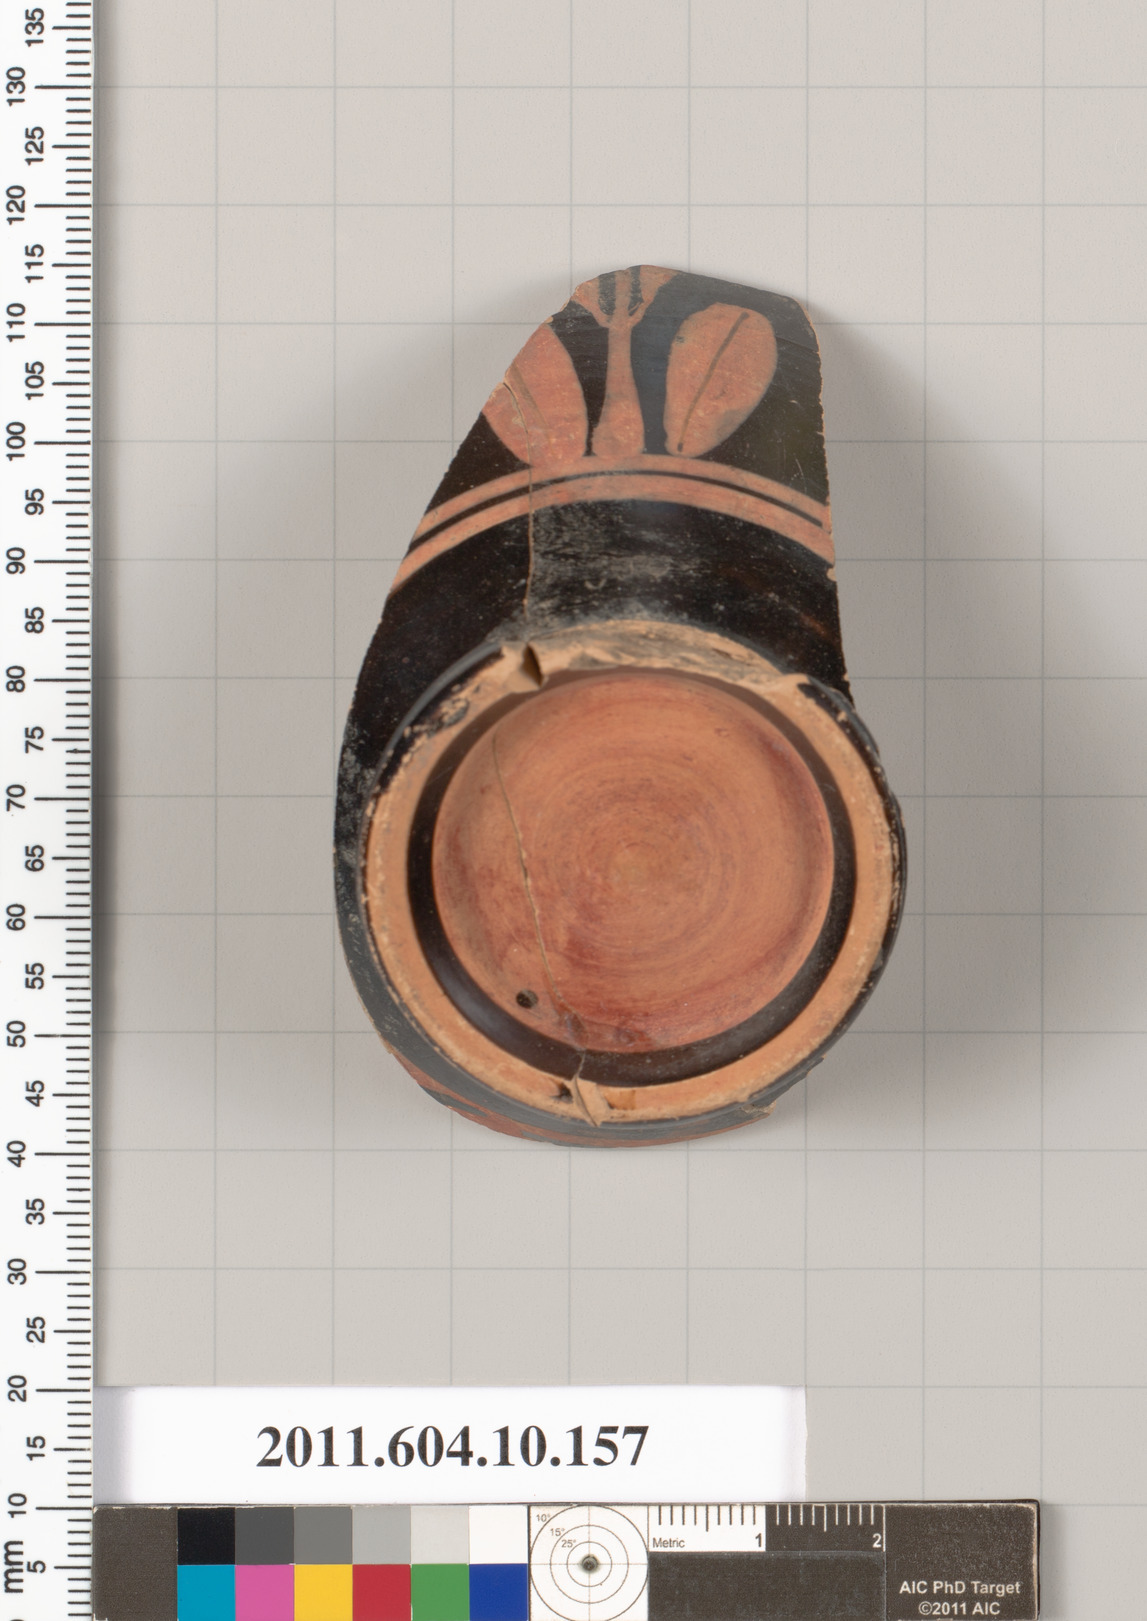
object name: skyphos fragment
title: Terracotta fragment of a skyphos (deep drinking cup)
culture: etruscan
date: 434-401 BCE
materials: terracotta